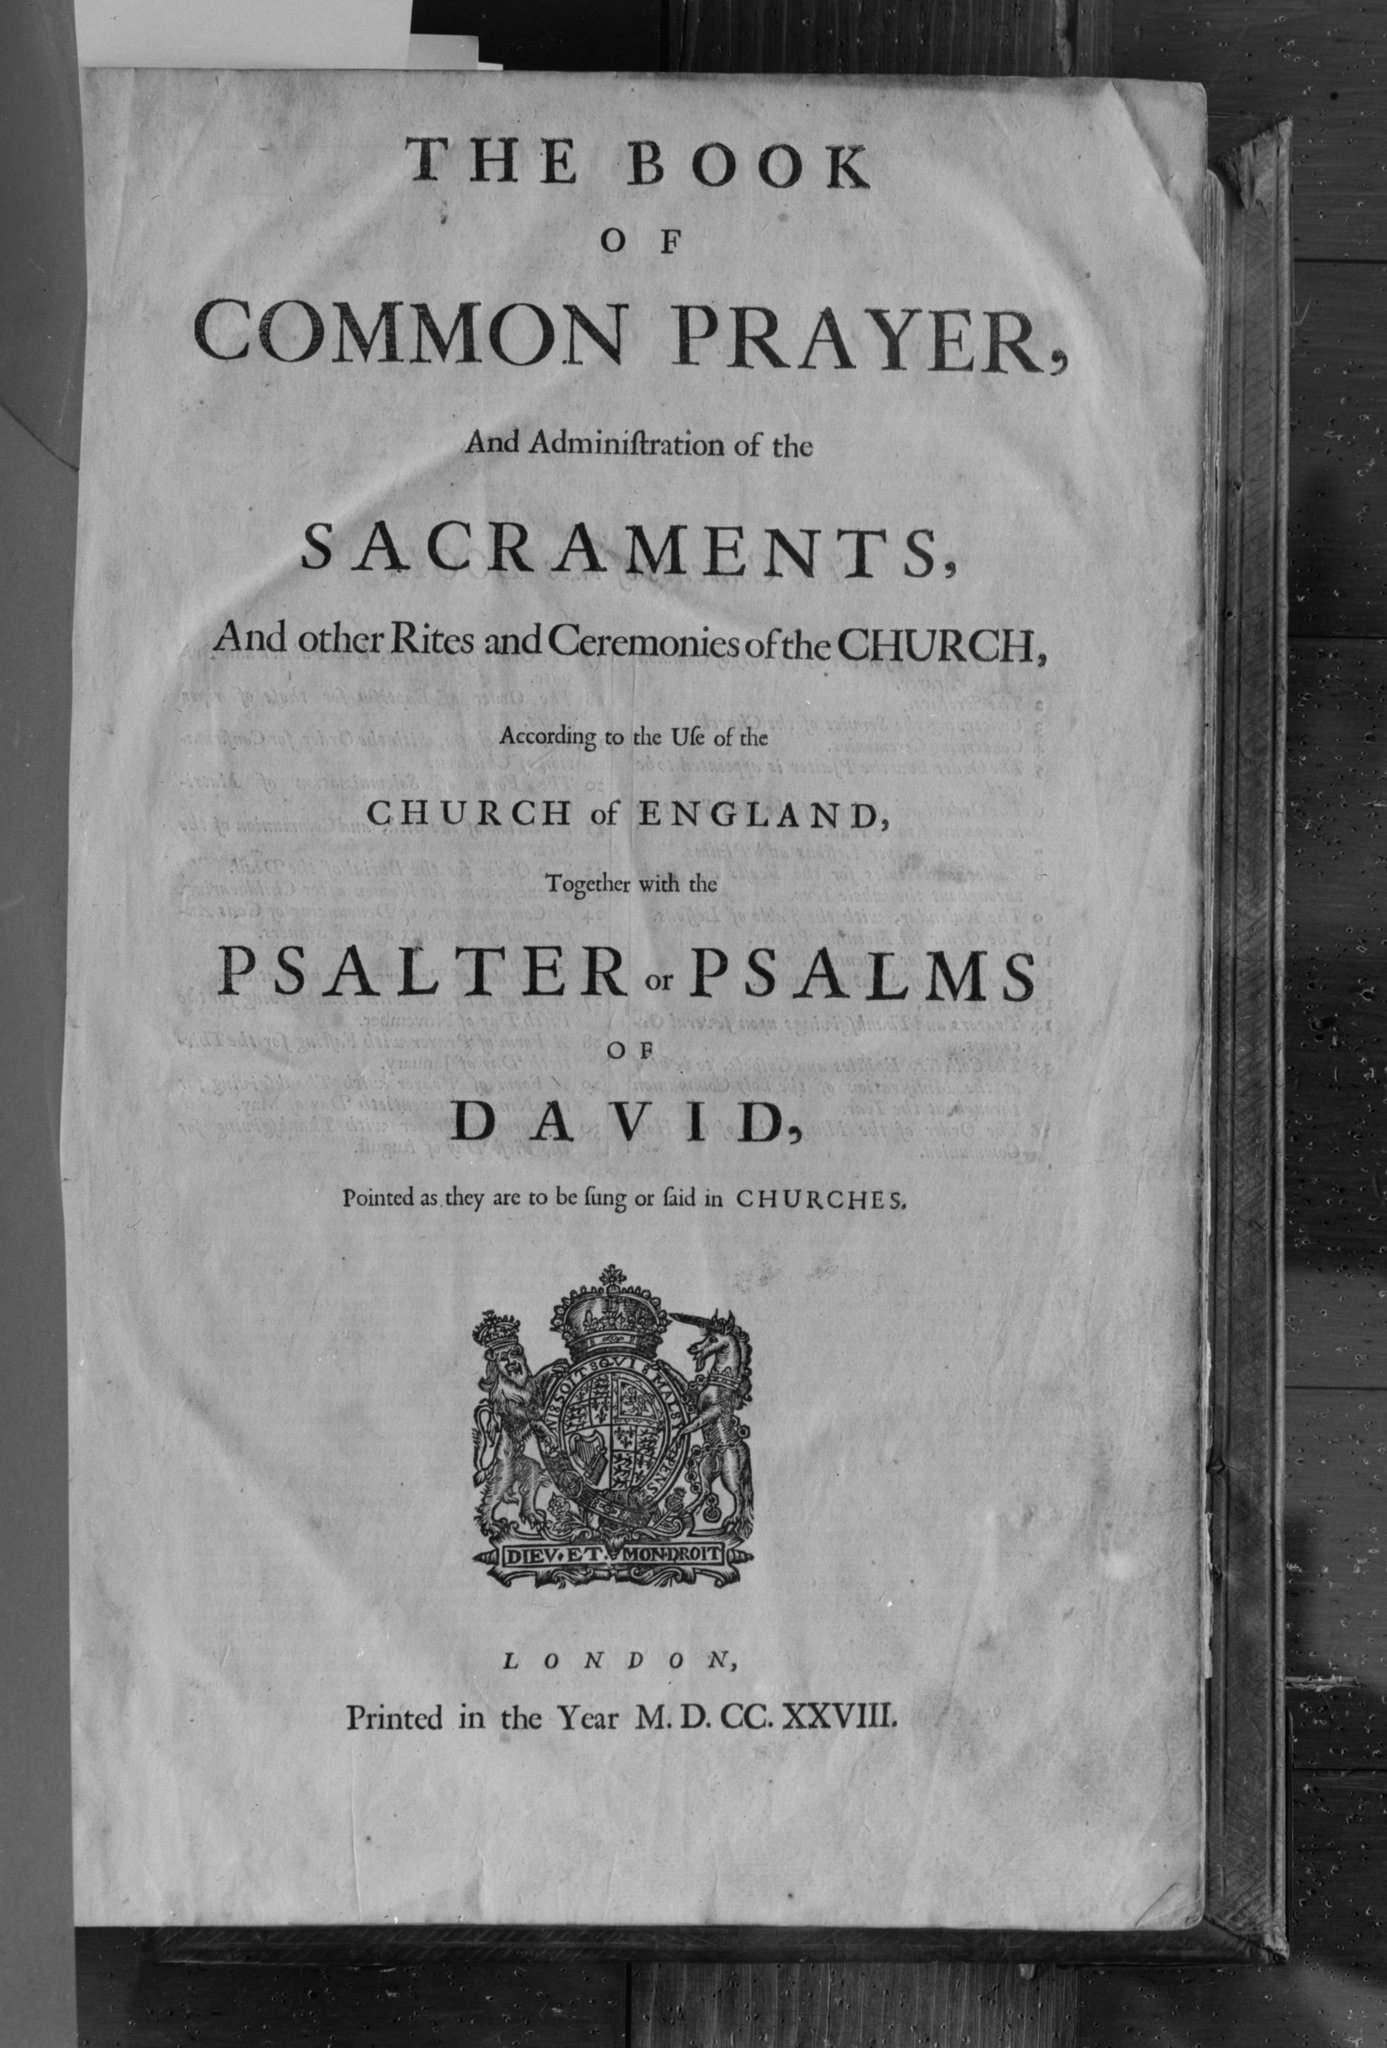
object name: book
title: Book of Common Prayer, Bible, and Book of Psalms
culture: british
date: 1715-1728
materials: paper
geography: england